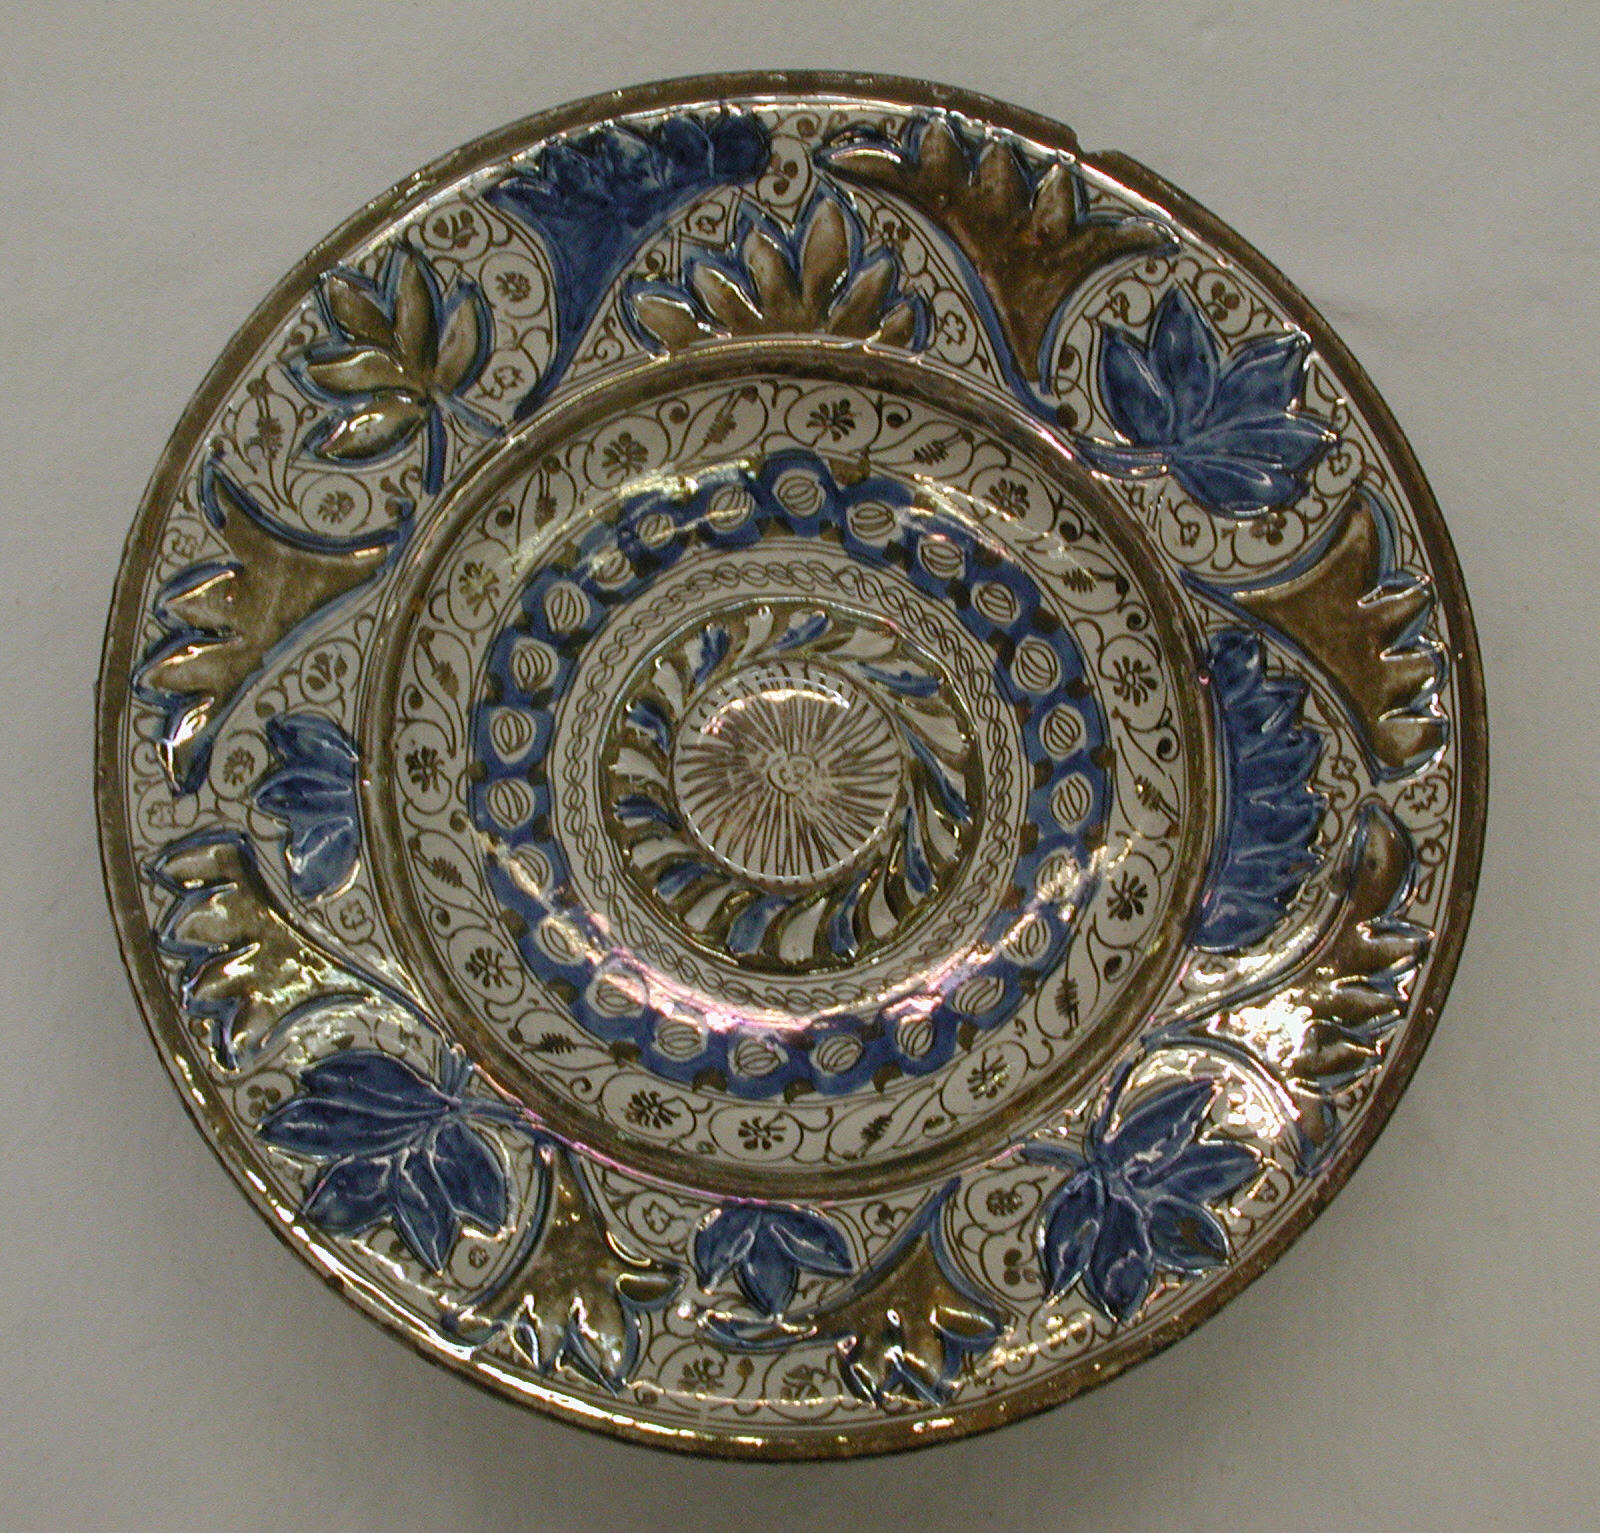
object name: dish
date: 1534-1566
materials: earthenware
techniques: luster painting, glazing